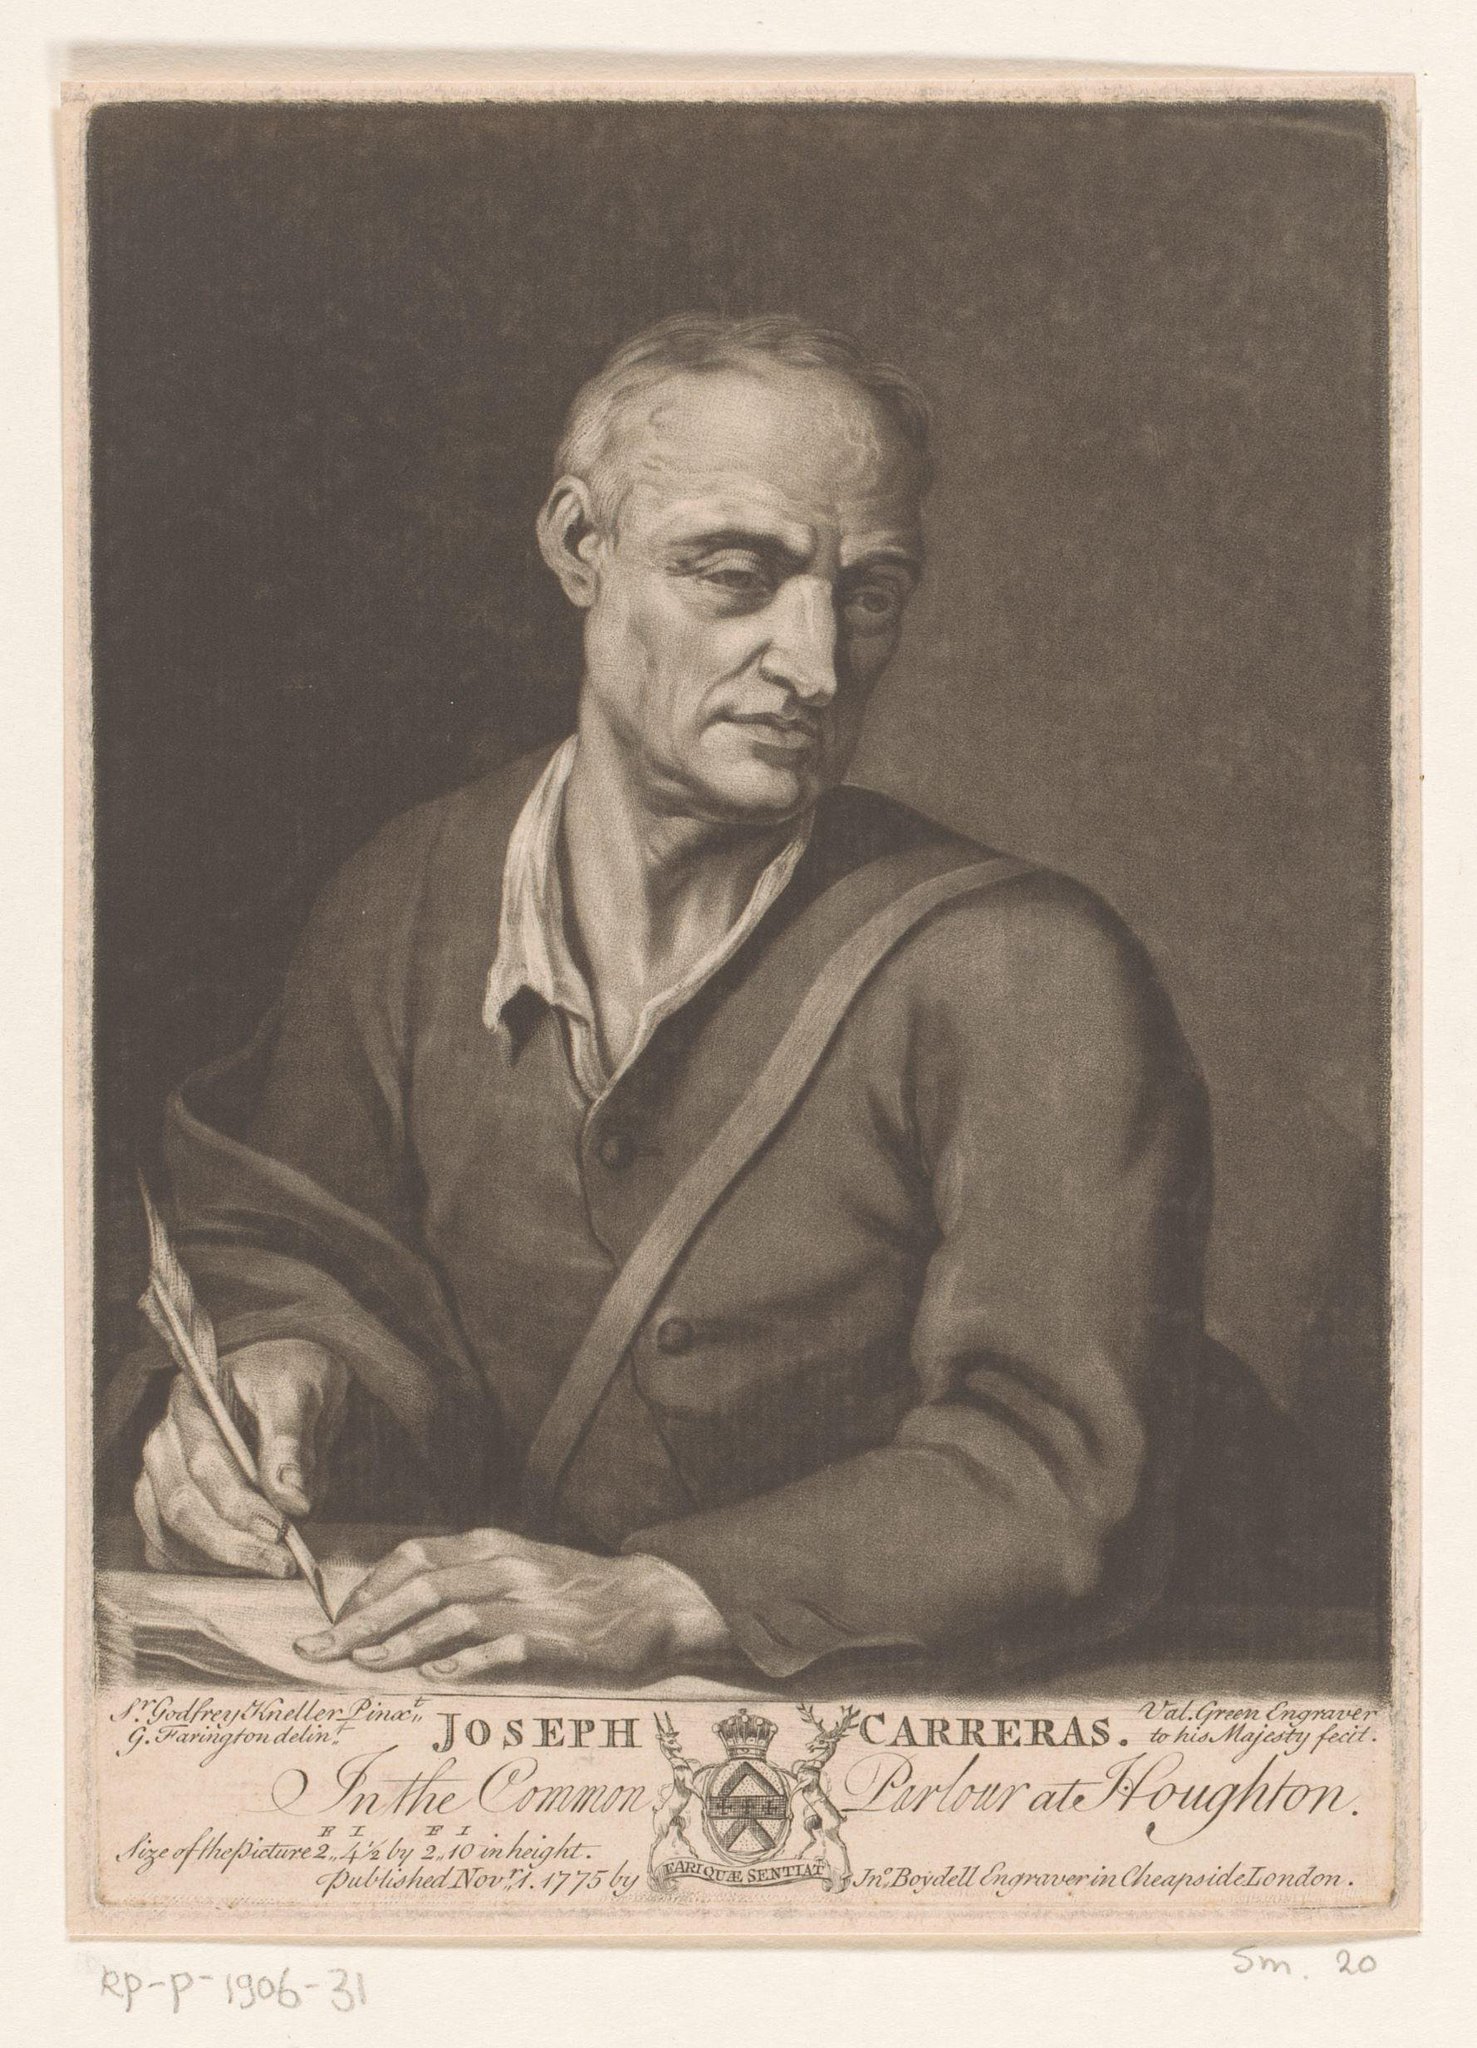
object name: print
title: Portret van Joseph Carreras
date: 1775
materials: paper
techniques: etching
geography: london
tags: historical persons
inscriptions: collector's mark: Lugt 2228